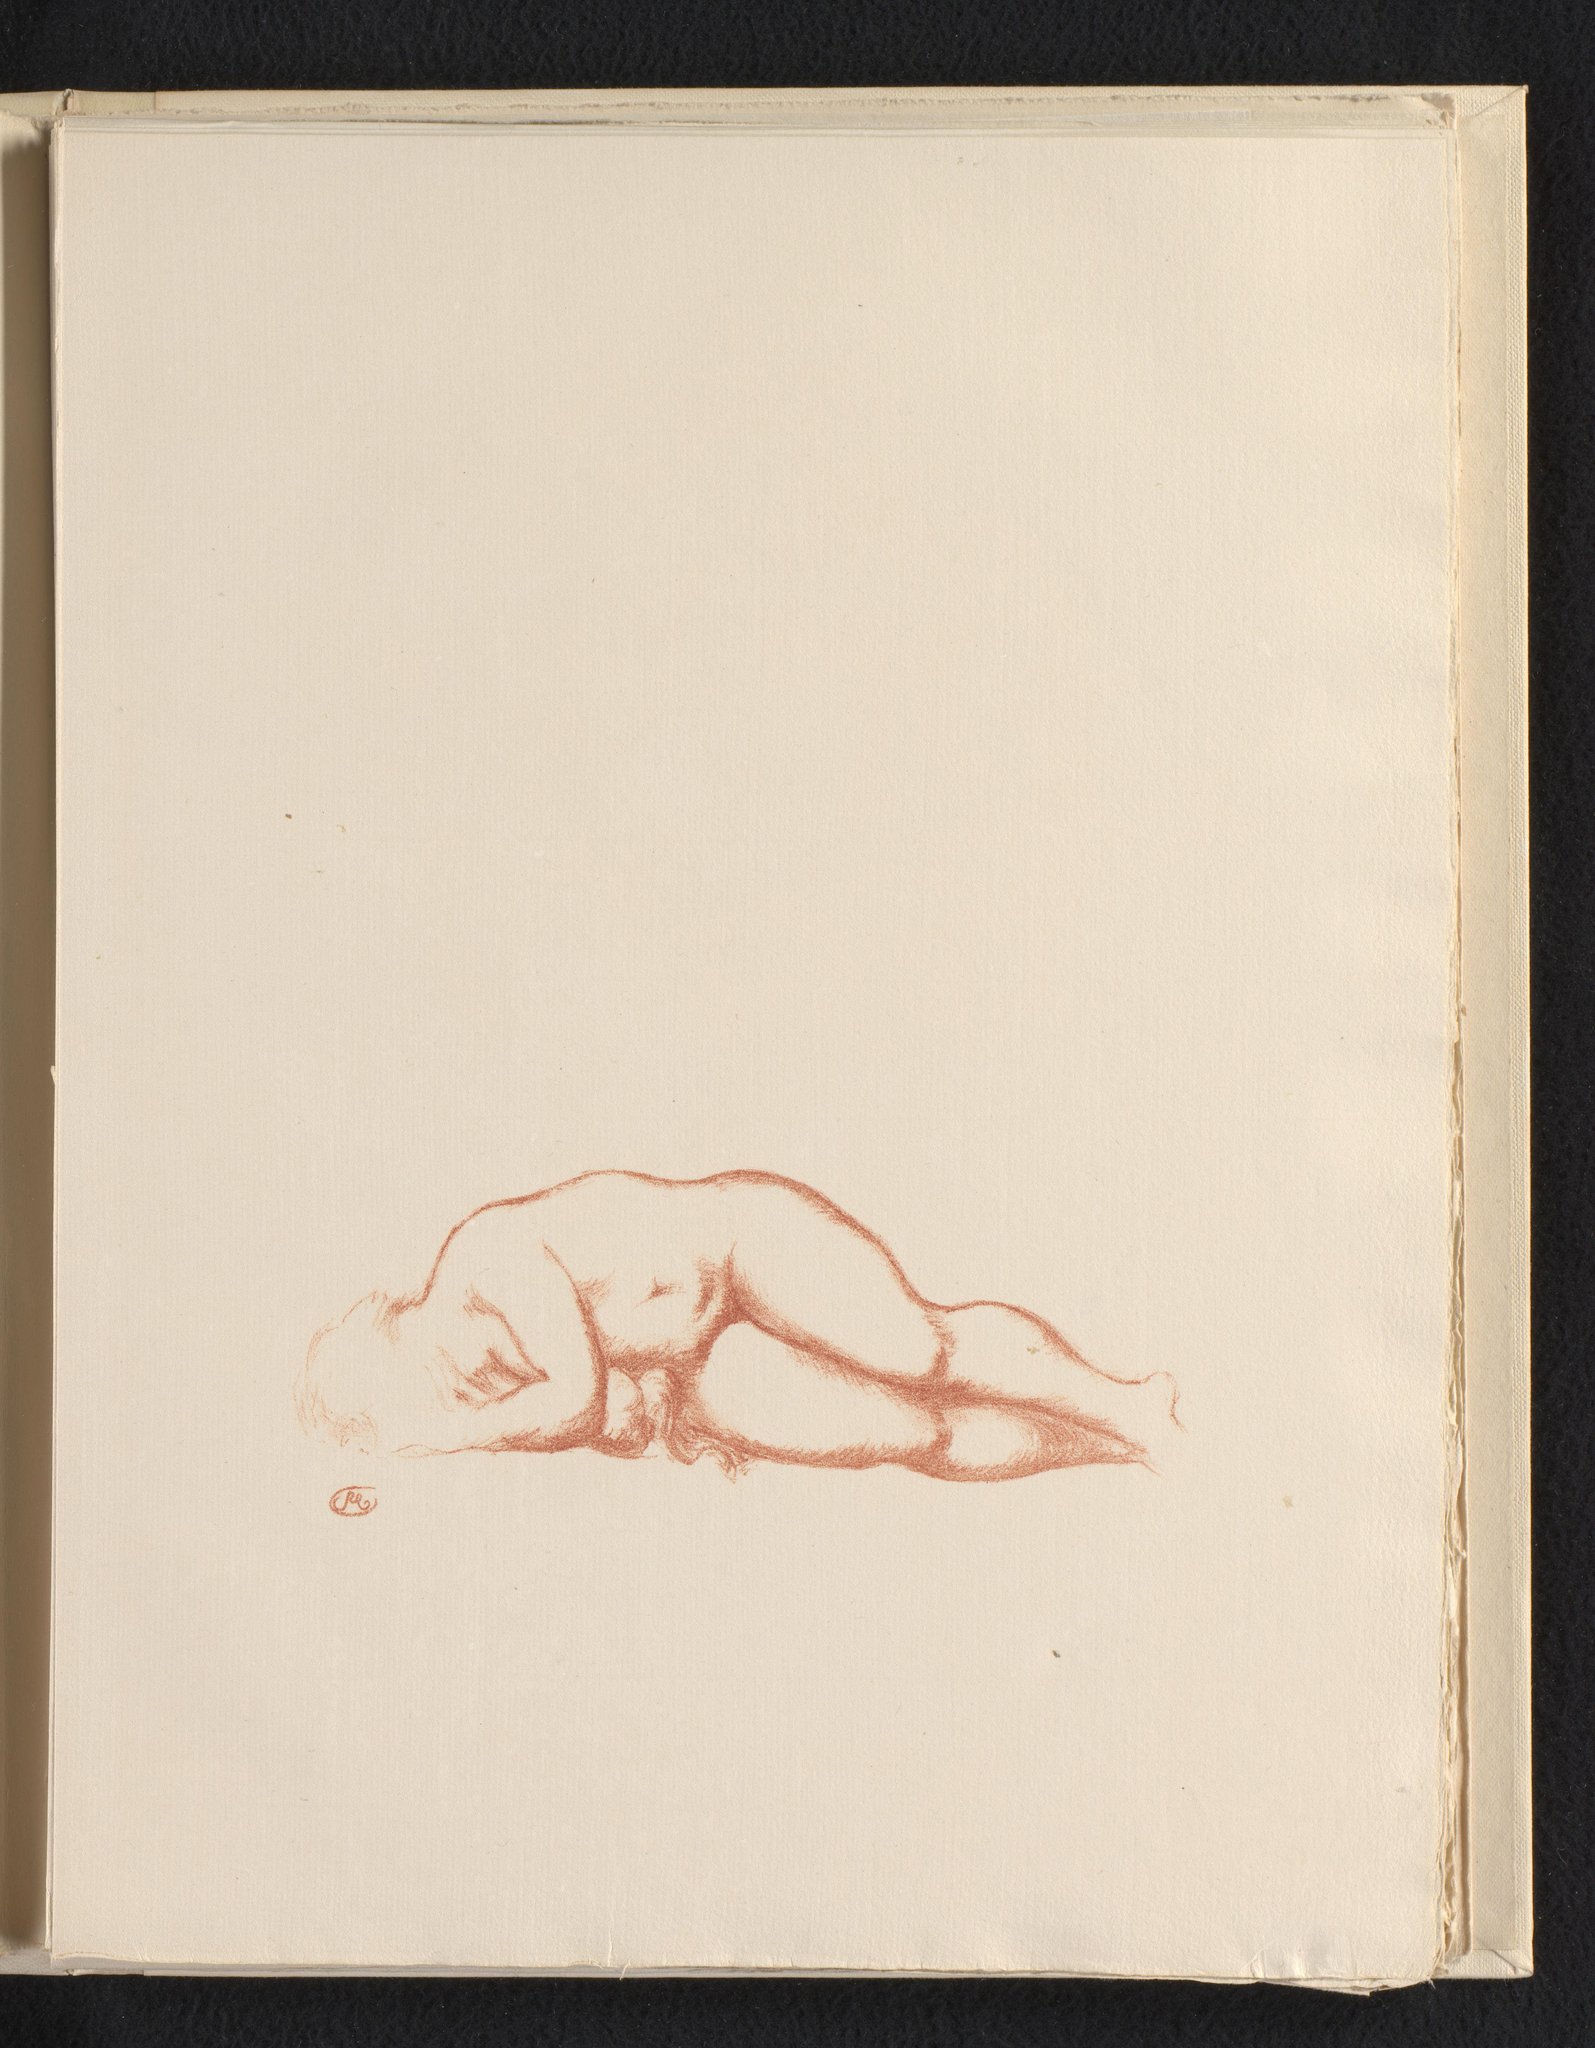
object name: book illustration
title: Liggende naakte vrouw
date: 1948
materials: paper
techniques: lithograph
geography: paris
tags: woman (showing herself) undressed, quasi-nude, sleeping on the ground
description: Prent uit: Lucianus van Samosata. Dialogues des Courtisanes. [Vertaald uit het Grieks door] Charles Astruc. Parijs: s.n., 1948, deel van de suite met een extra afdruk van de prenten in sanguine.